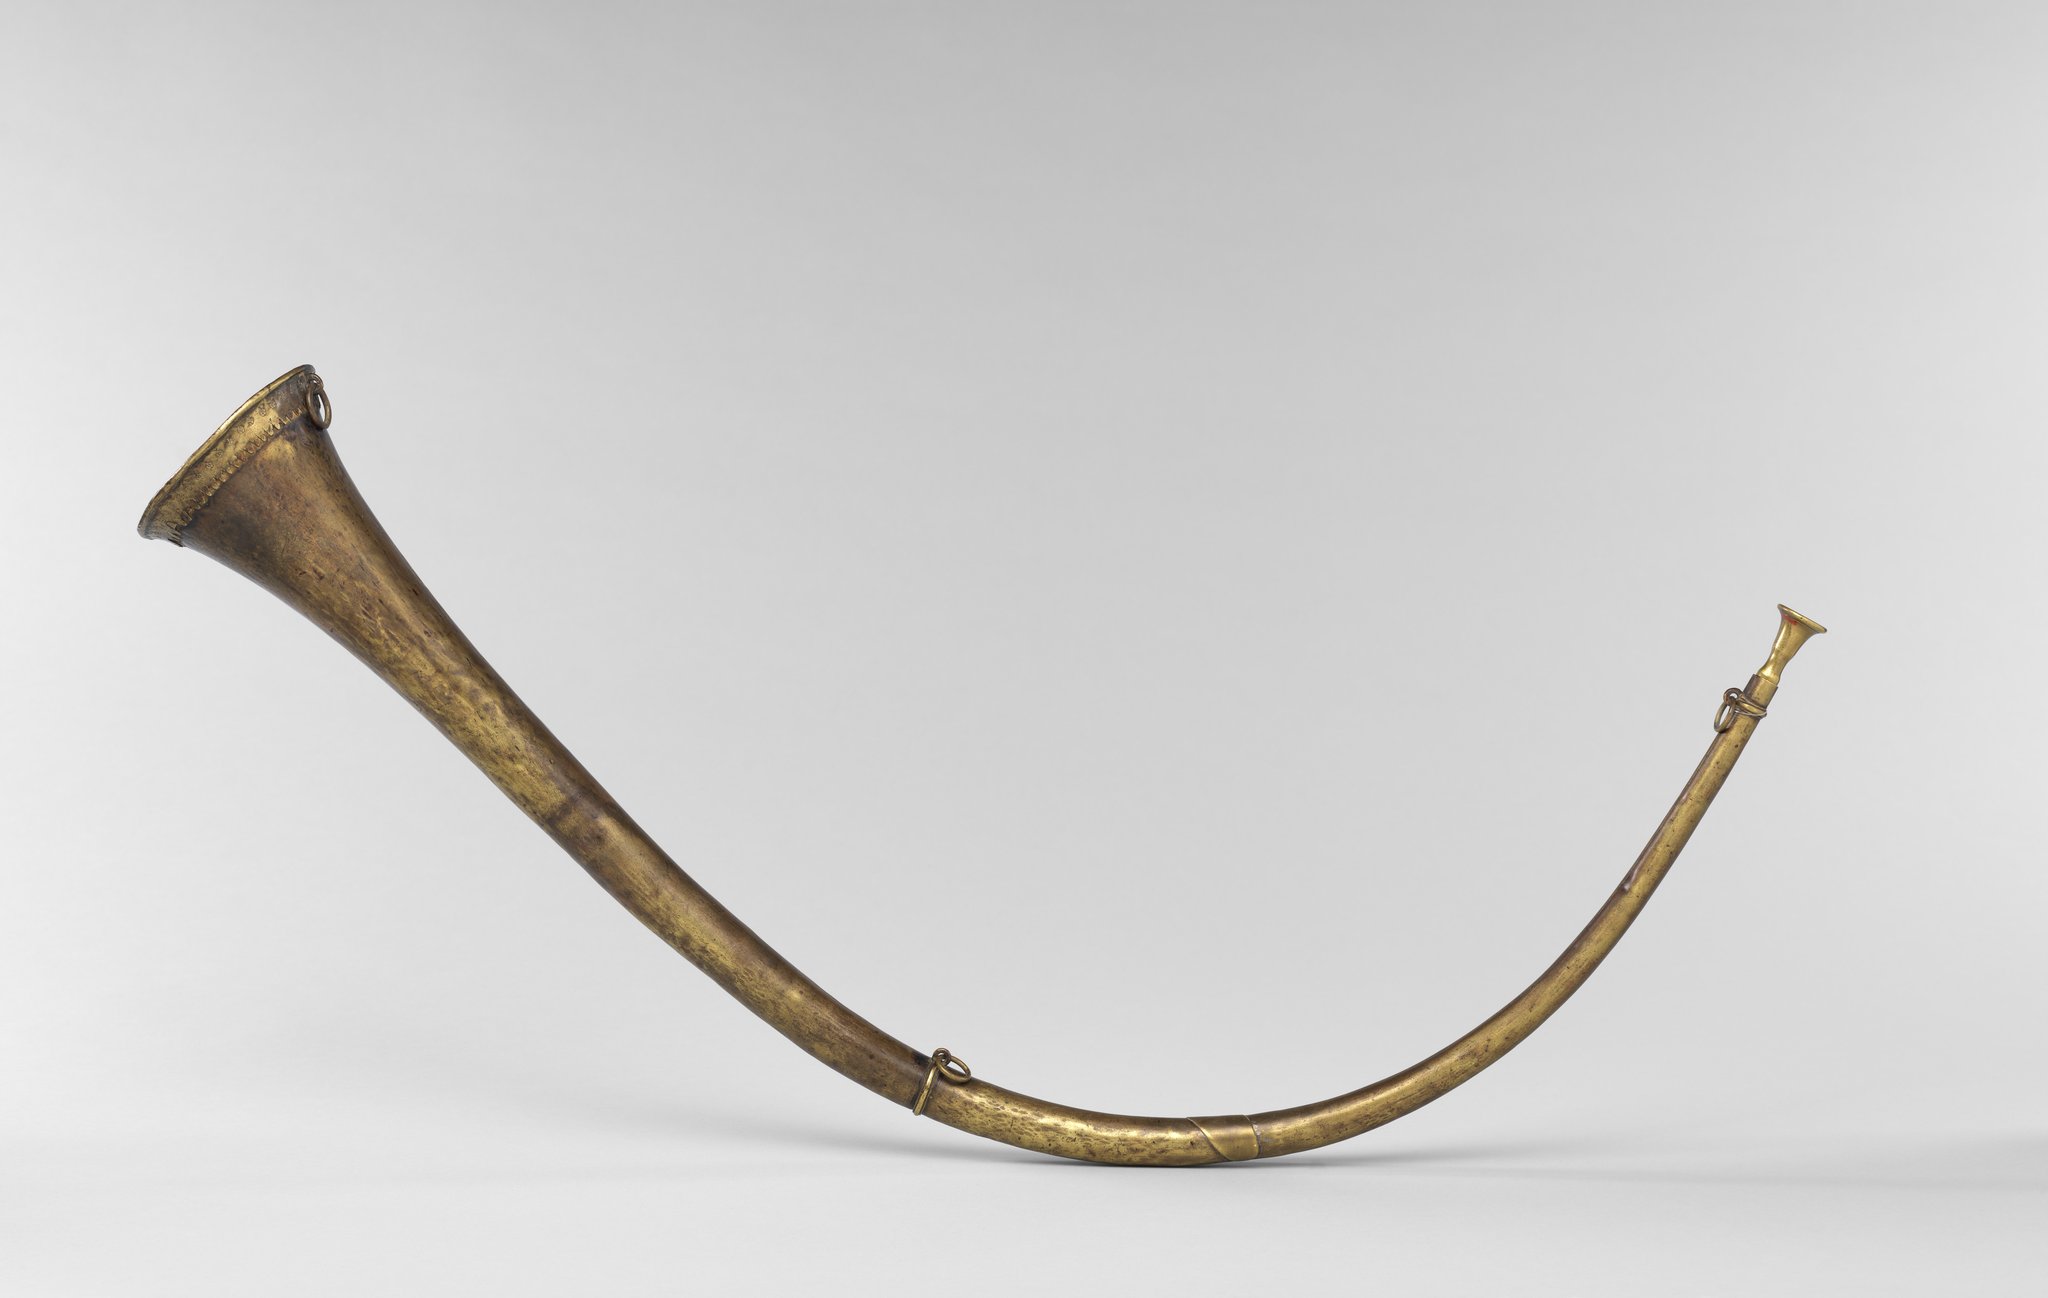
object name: demilune horn grand cor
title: Demilune horn "grand cor"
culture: french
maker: cretien workshop, vernon (c.1620 – ca. 1690)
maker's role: maker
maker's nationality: french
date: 1601-1633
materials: brass